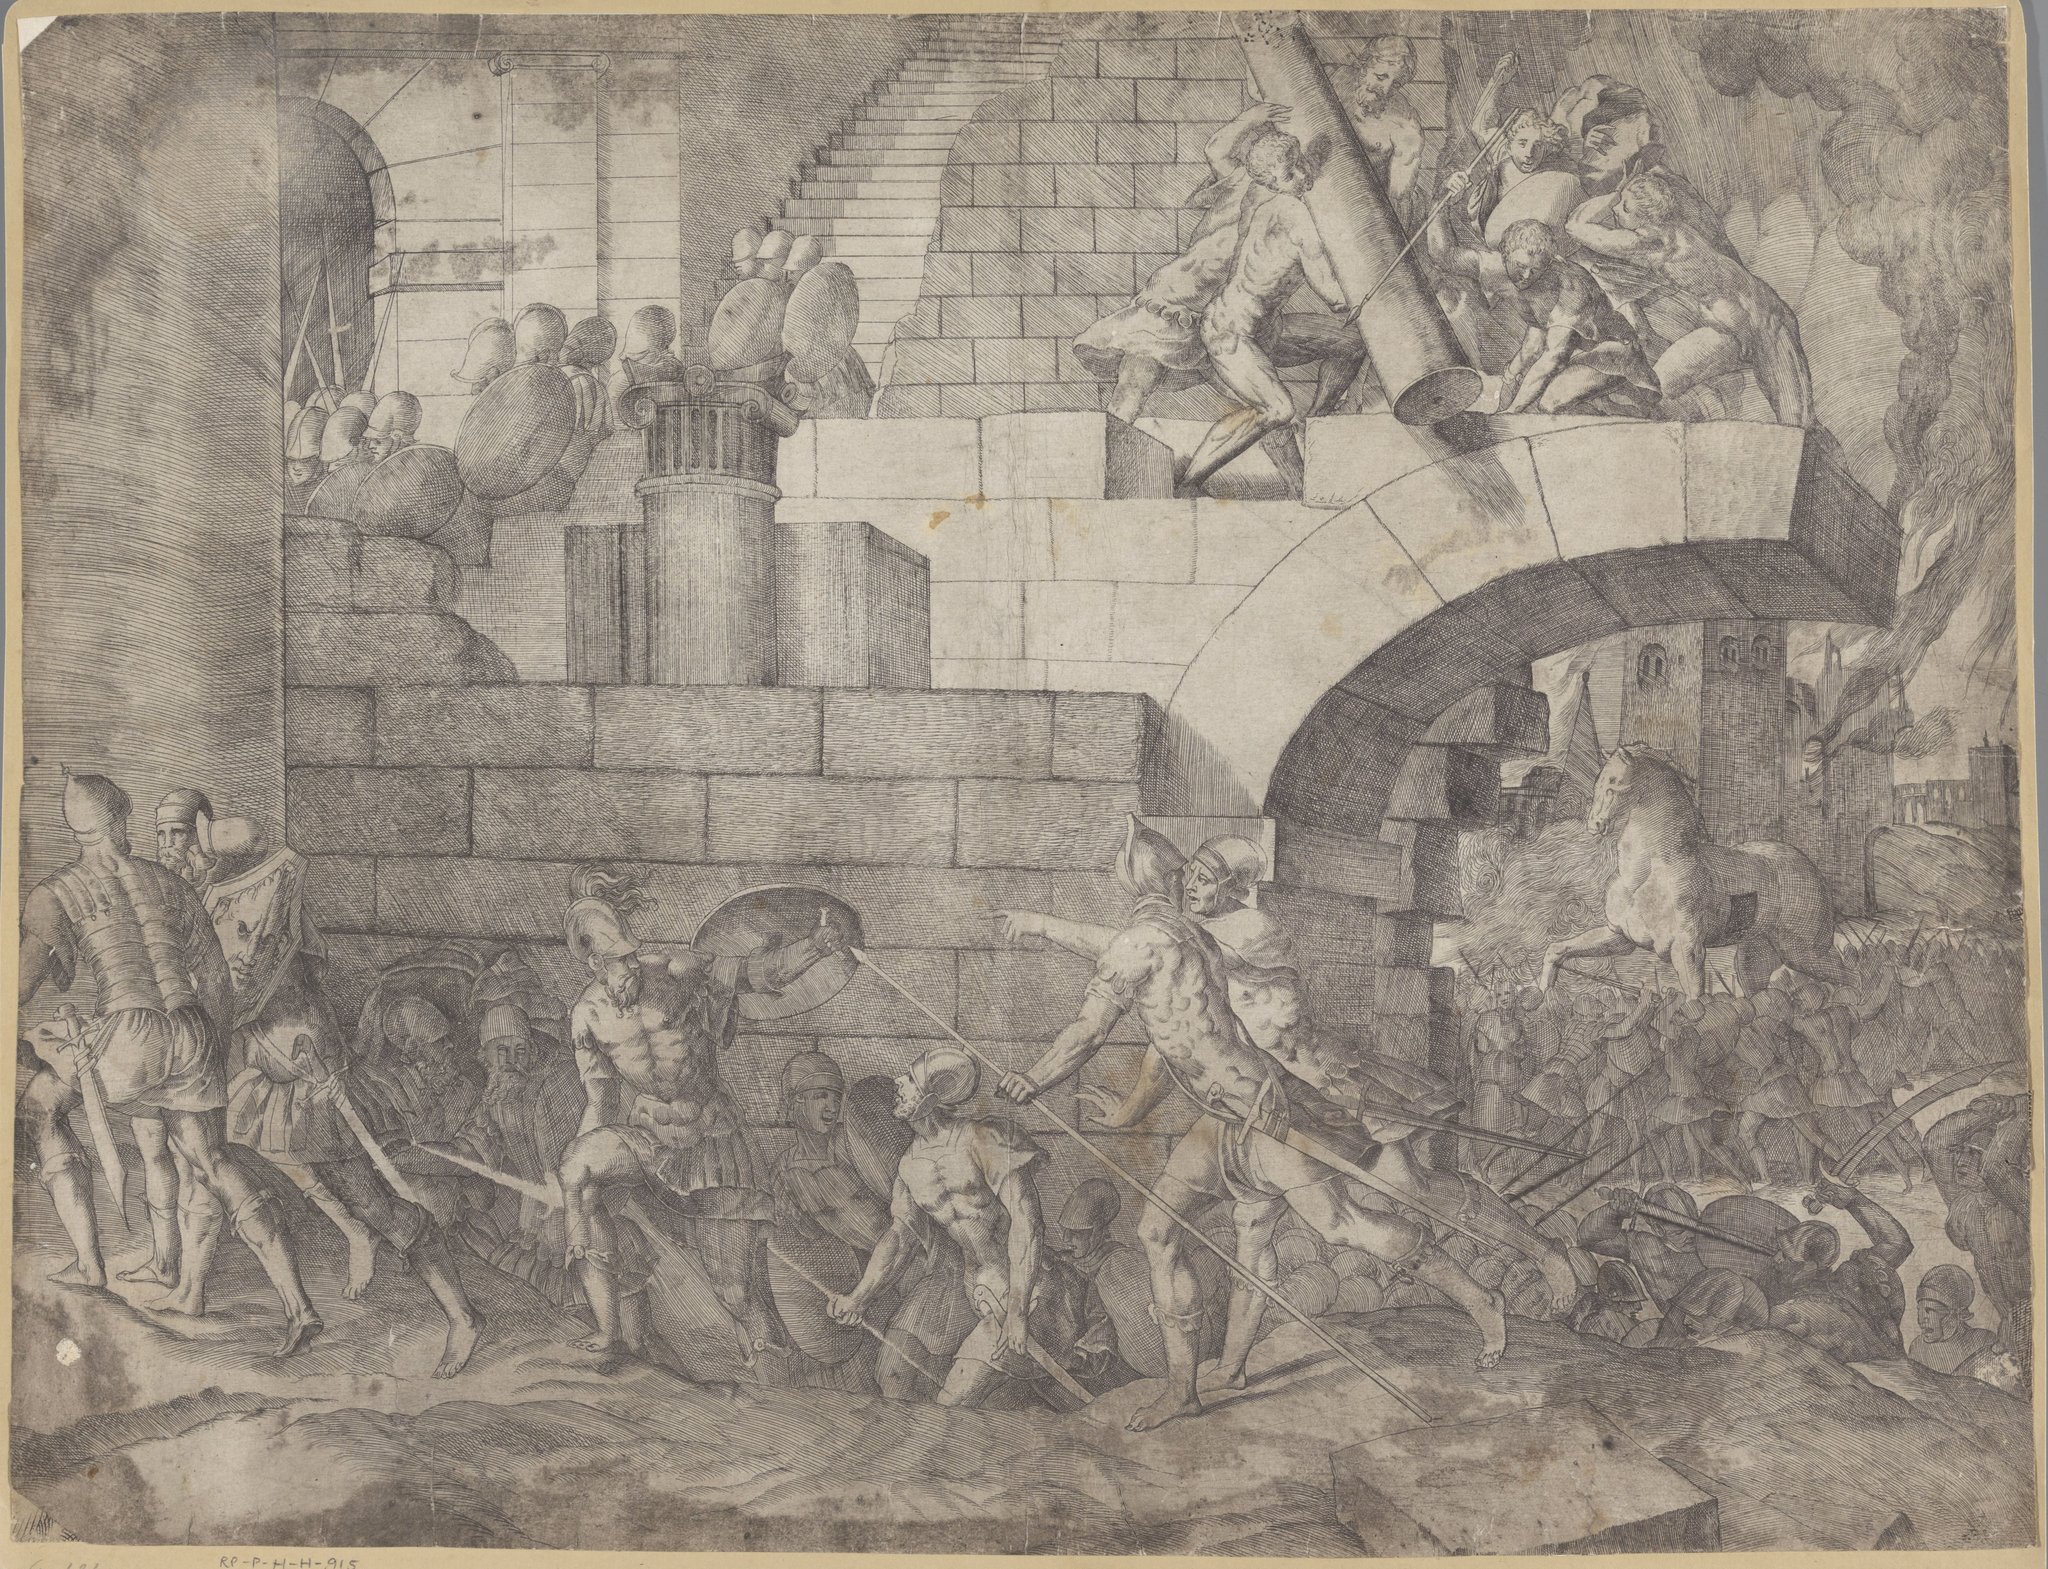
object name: print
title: Gevecht bij de muren van Troje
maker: giulio fontana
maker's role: print maker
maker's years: 1543-1582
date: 1553-1582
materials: paper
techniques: etching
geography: italy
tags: the trojan horse, battle, the fall of troy; troy burning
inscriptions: collector's mark: Lugt 11, collector's mark: Lugt 10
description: De strijd tussen Griekse en Trojaanse soldaten voor de muren van Troje. Op de achtergrond soldaten rond het paard van Troje en brandende gebouwen in de stad.